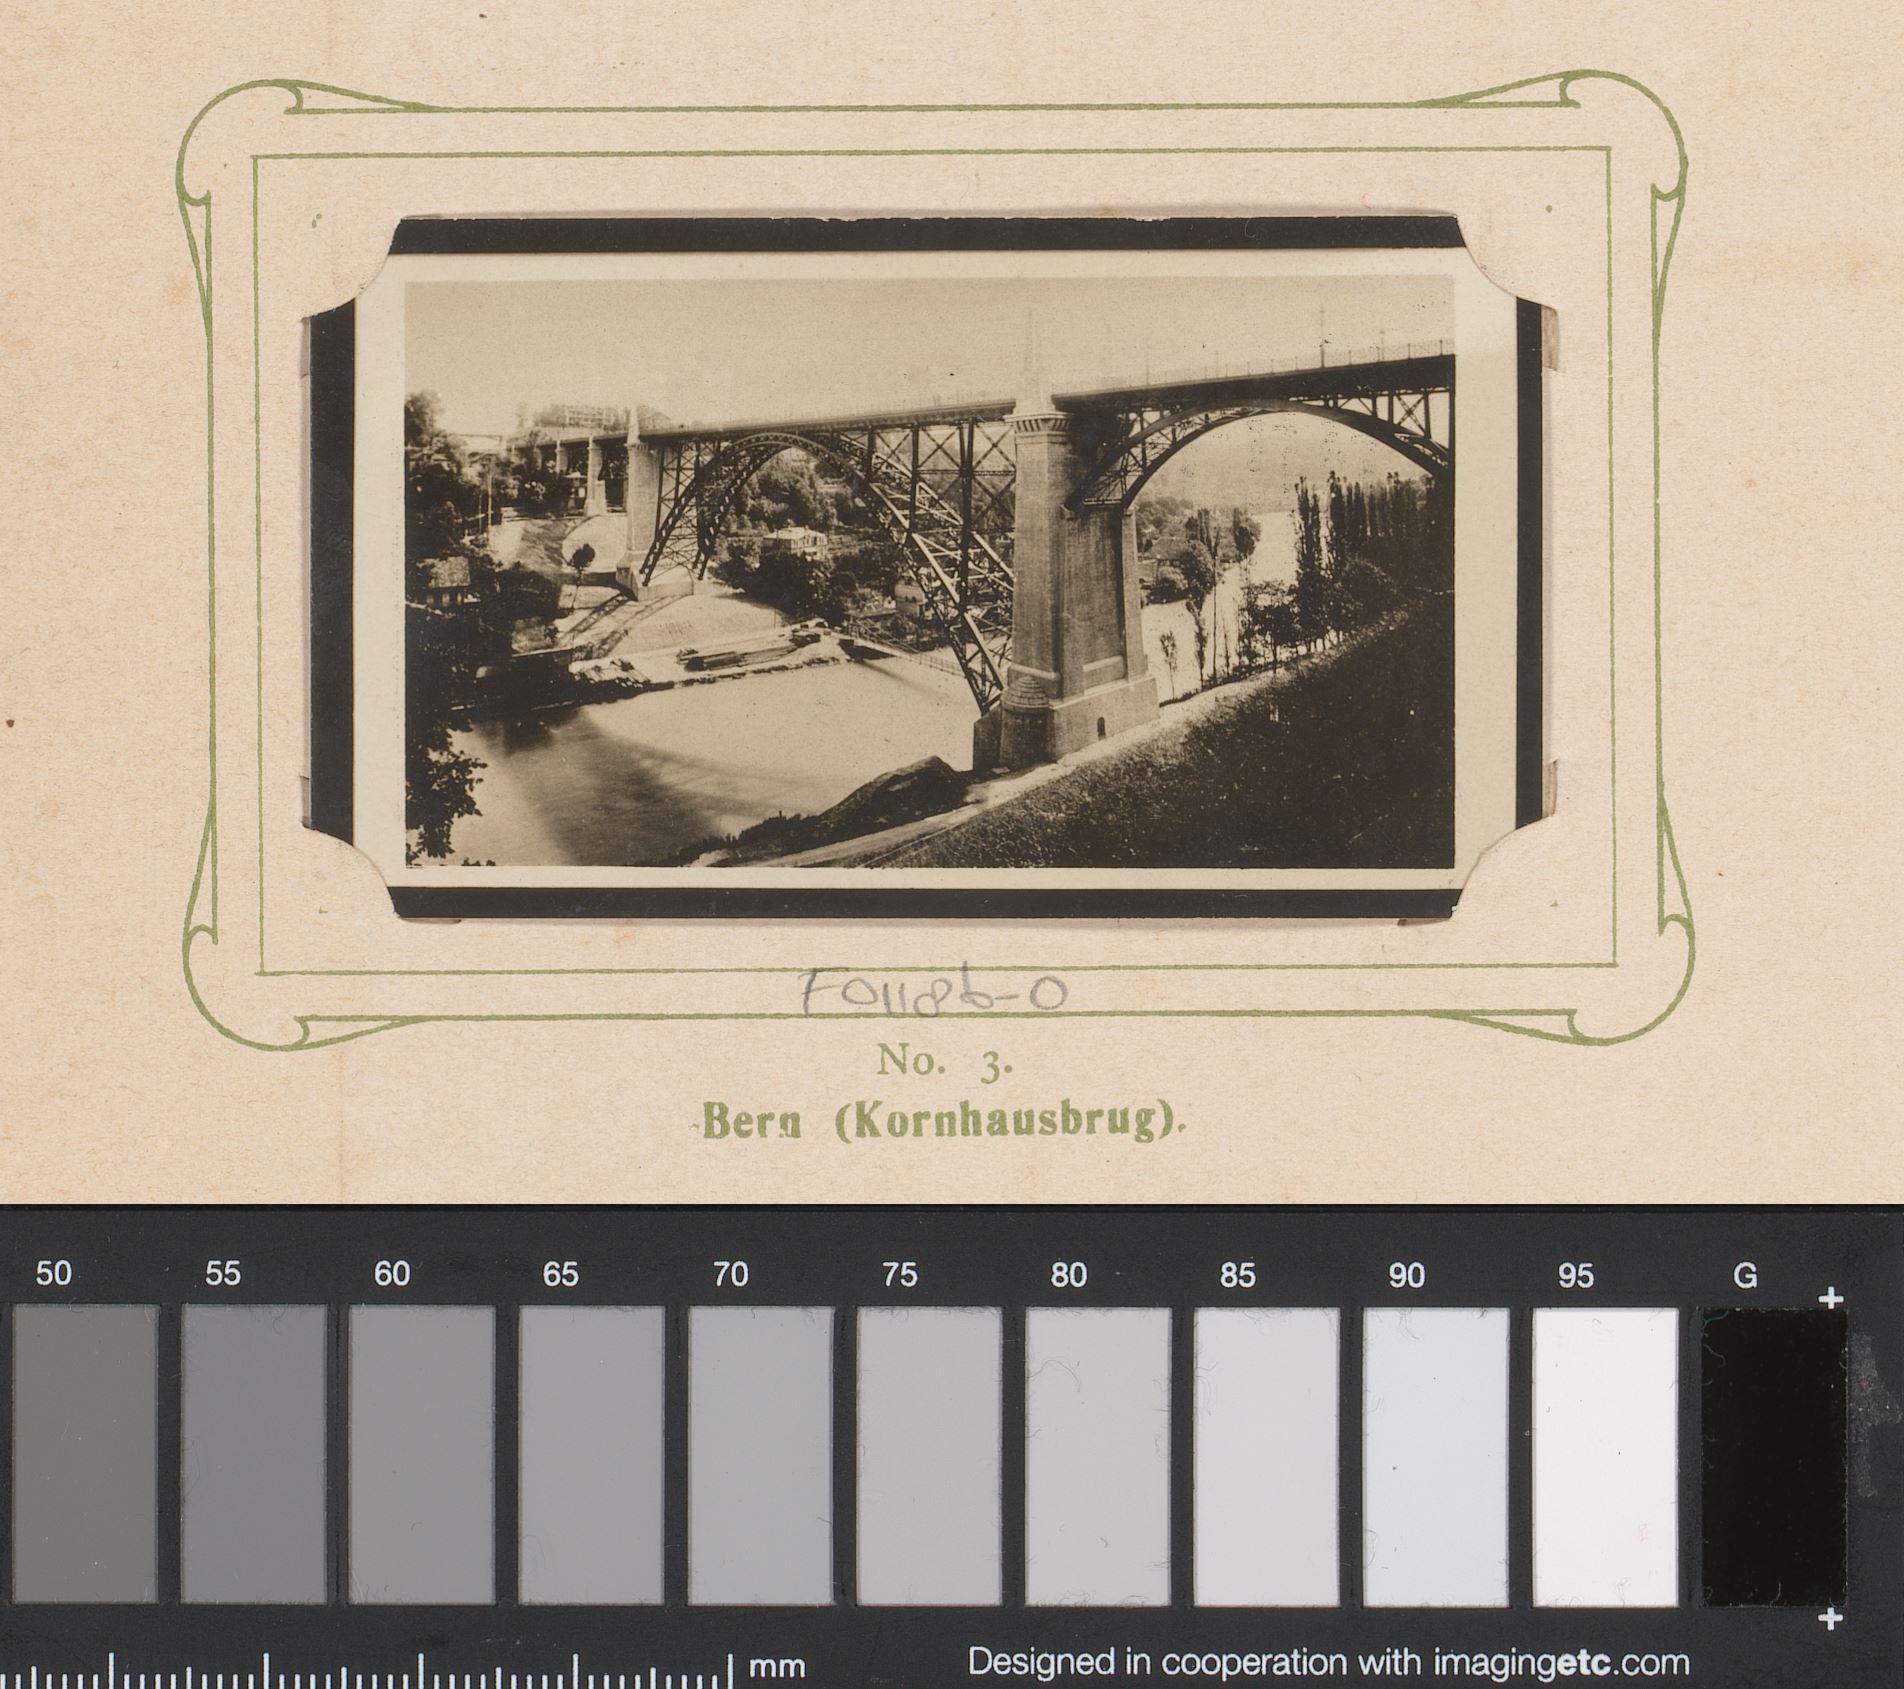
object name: photograph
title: Gezicht op de Kornhaus brug te Bern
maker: Anonymous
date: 1904-1905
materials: photographic support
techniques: gelatin silver print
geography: zermatt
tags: landscape with bridge, viaduct or aqueduct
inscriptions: inscription: ‘No. 3./ Bern (Kornhausbrug).’